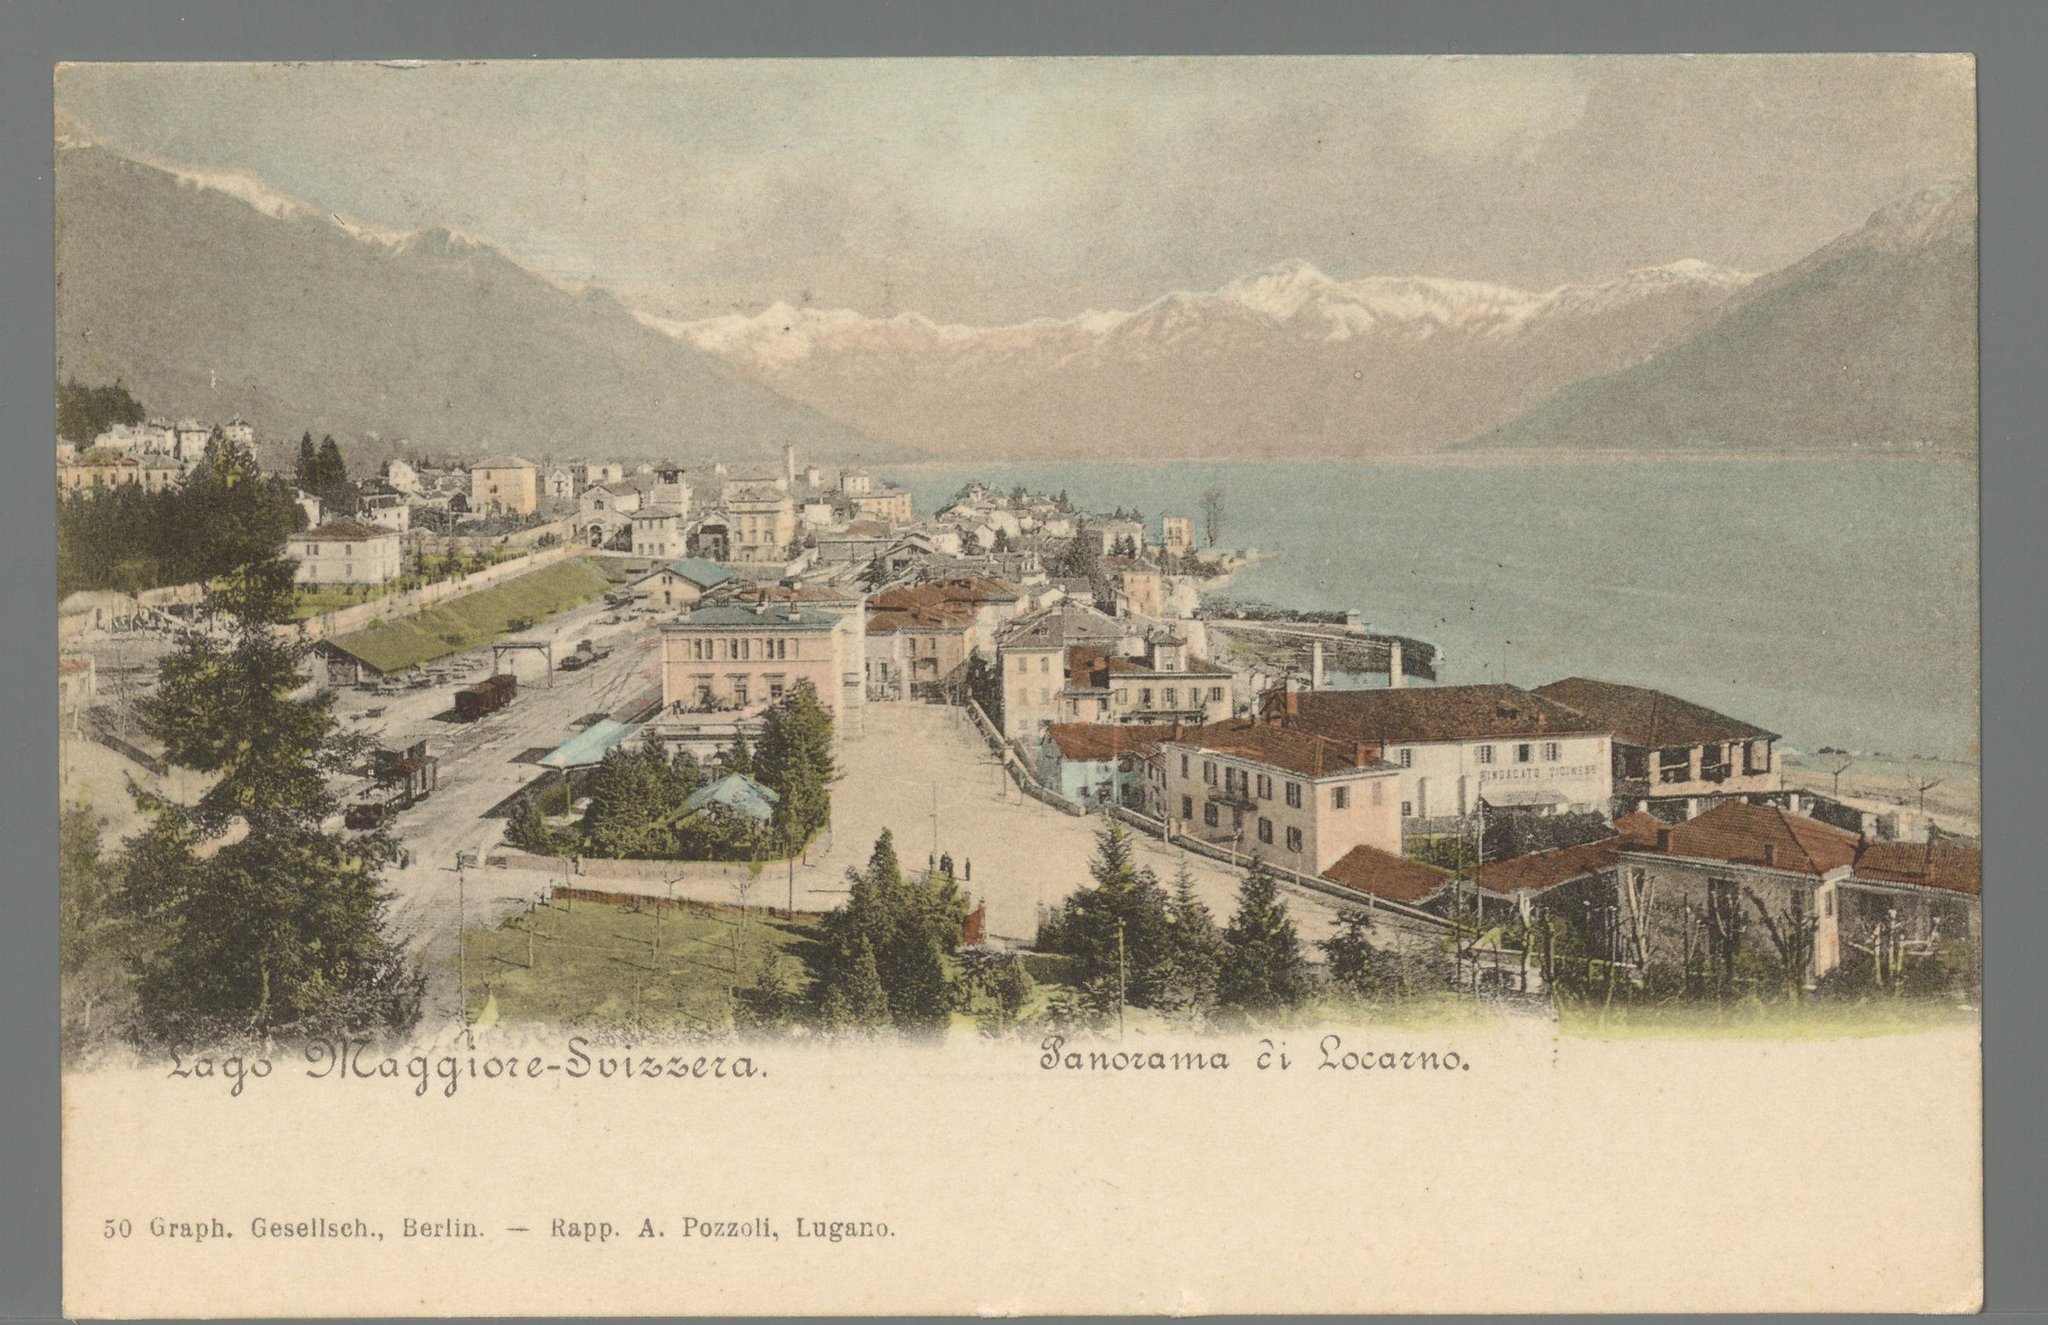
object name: photomechanical print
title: Lago Maggiore-Svizzera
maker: attilio pozzoli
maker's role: publisher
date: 1897-1902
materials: cardboard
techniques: photograph, lithograph, writing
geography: berlin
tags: lake, mountain-range, snow peaks, prospect of city, town panorama, silhouette of city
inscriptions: postage stamp